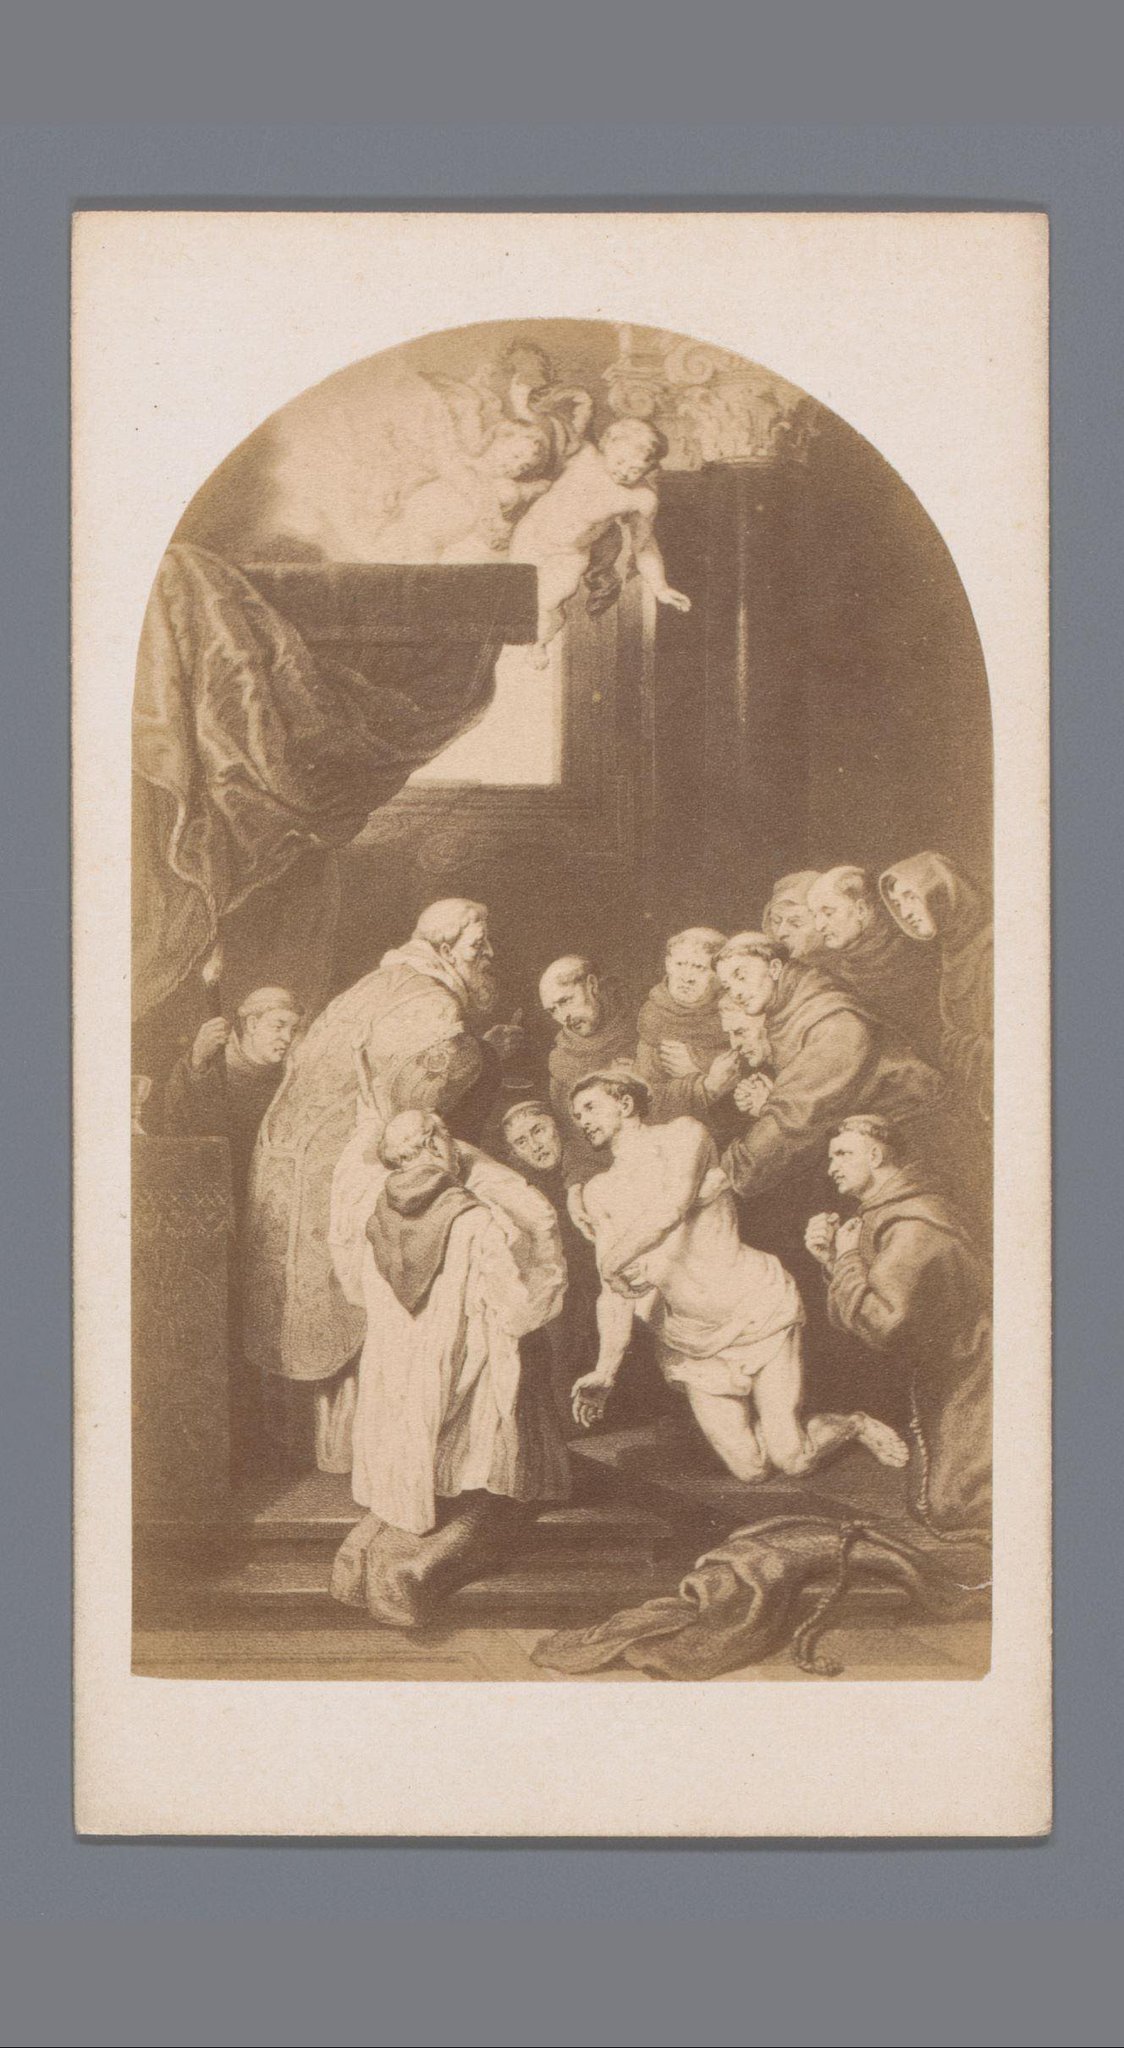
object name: carte de visite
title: Anvers Tableaux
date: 1858-1866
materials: cardboard, paper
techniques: albumen print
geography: antwerp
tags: last communion, administering of the holy viaticum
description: Het schilderij van Rubens bevindt zich nu in het Museum voor Schone Kunsten te Antwerpen.